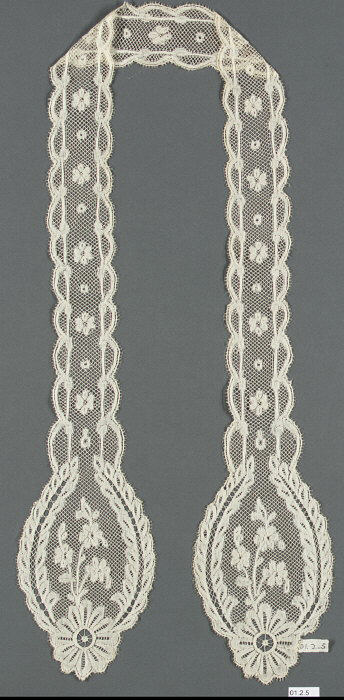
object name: lappet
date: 1801-1900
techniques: lace